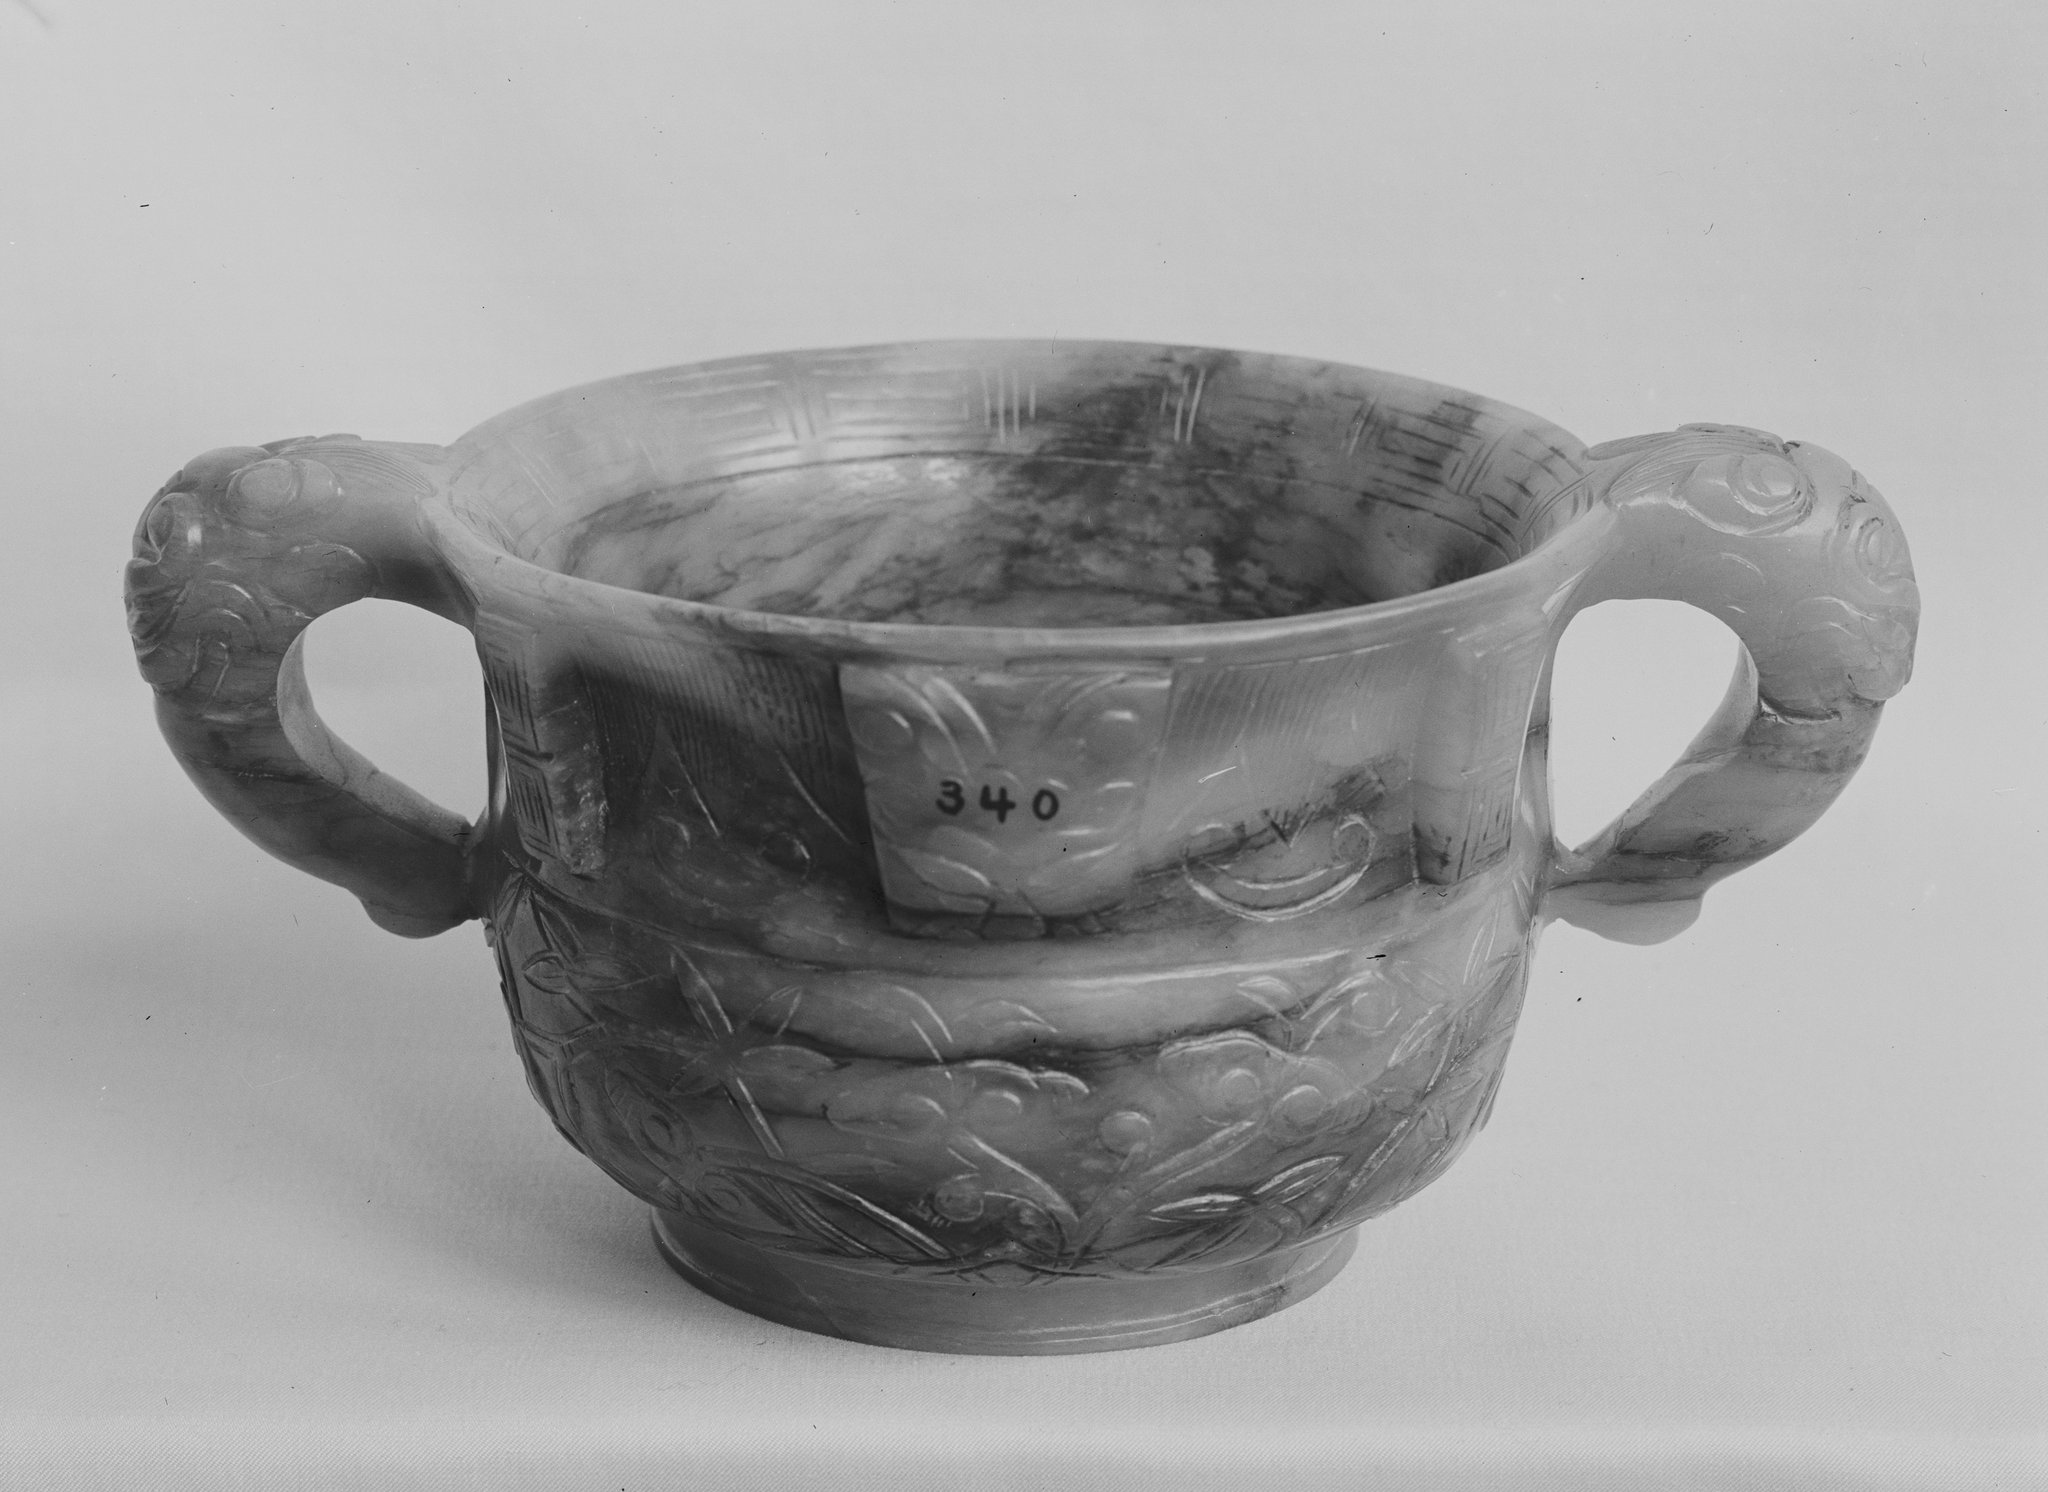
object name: vessel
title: Sacrificial Vessel (Yi lu)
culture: chinese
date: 1368-1644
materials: jade